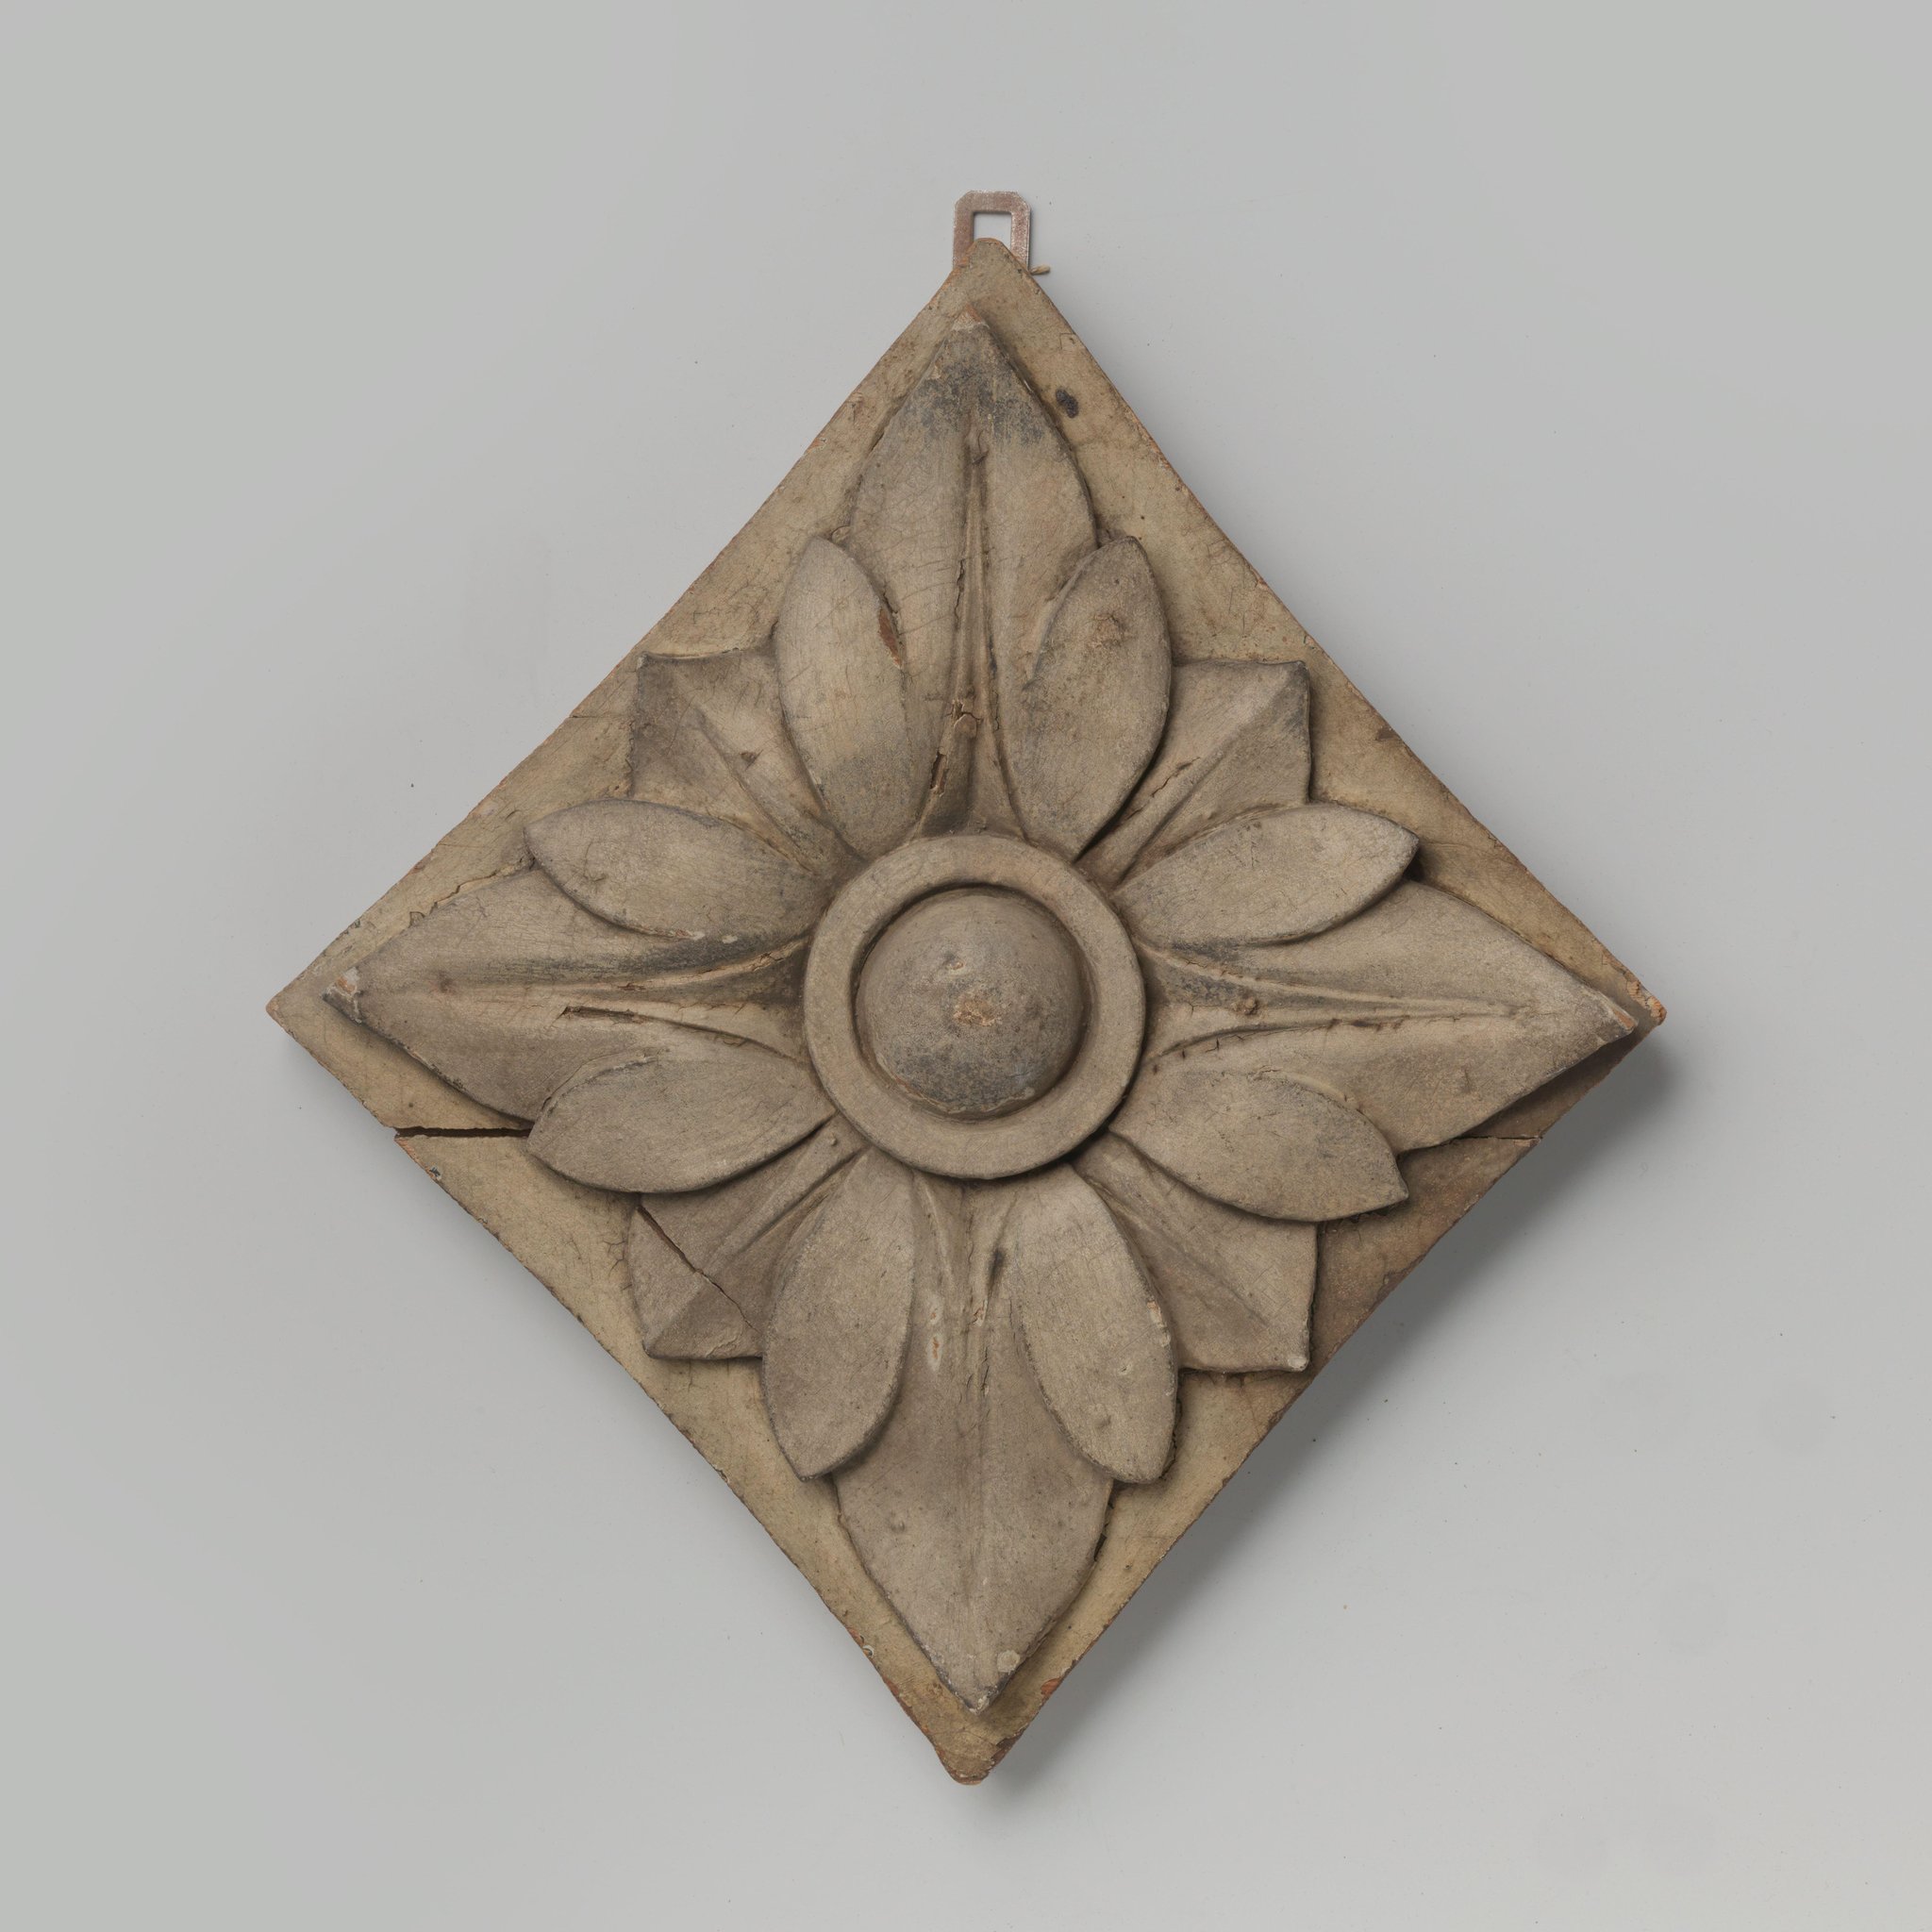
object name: ornament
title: Interieuronderdeel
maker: Anonymous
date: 1600-1699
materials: wood, paint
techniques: painted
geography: northern netherlands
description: Ruitvormig houten ornament, vermoedelijk afkomstig van een plafond. Op de ruitvormige vlakke ondergrond van eikenhout met enigszins naar binnen gebogen zijden, is in eikenhout een en-reliëf gesneden bloem aangebracht. Zie tevens: BK-18860-b.